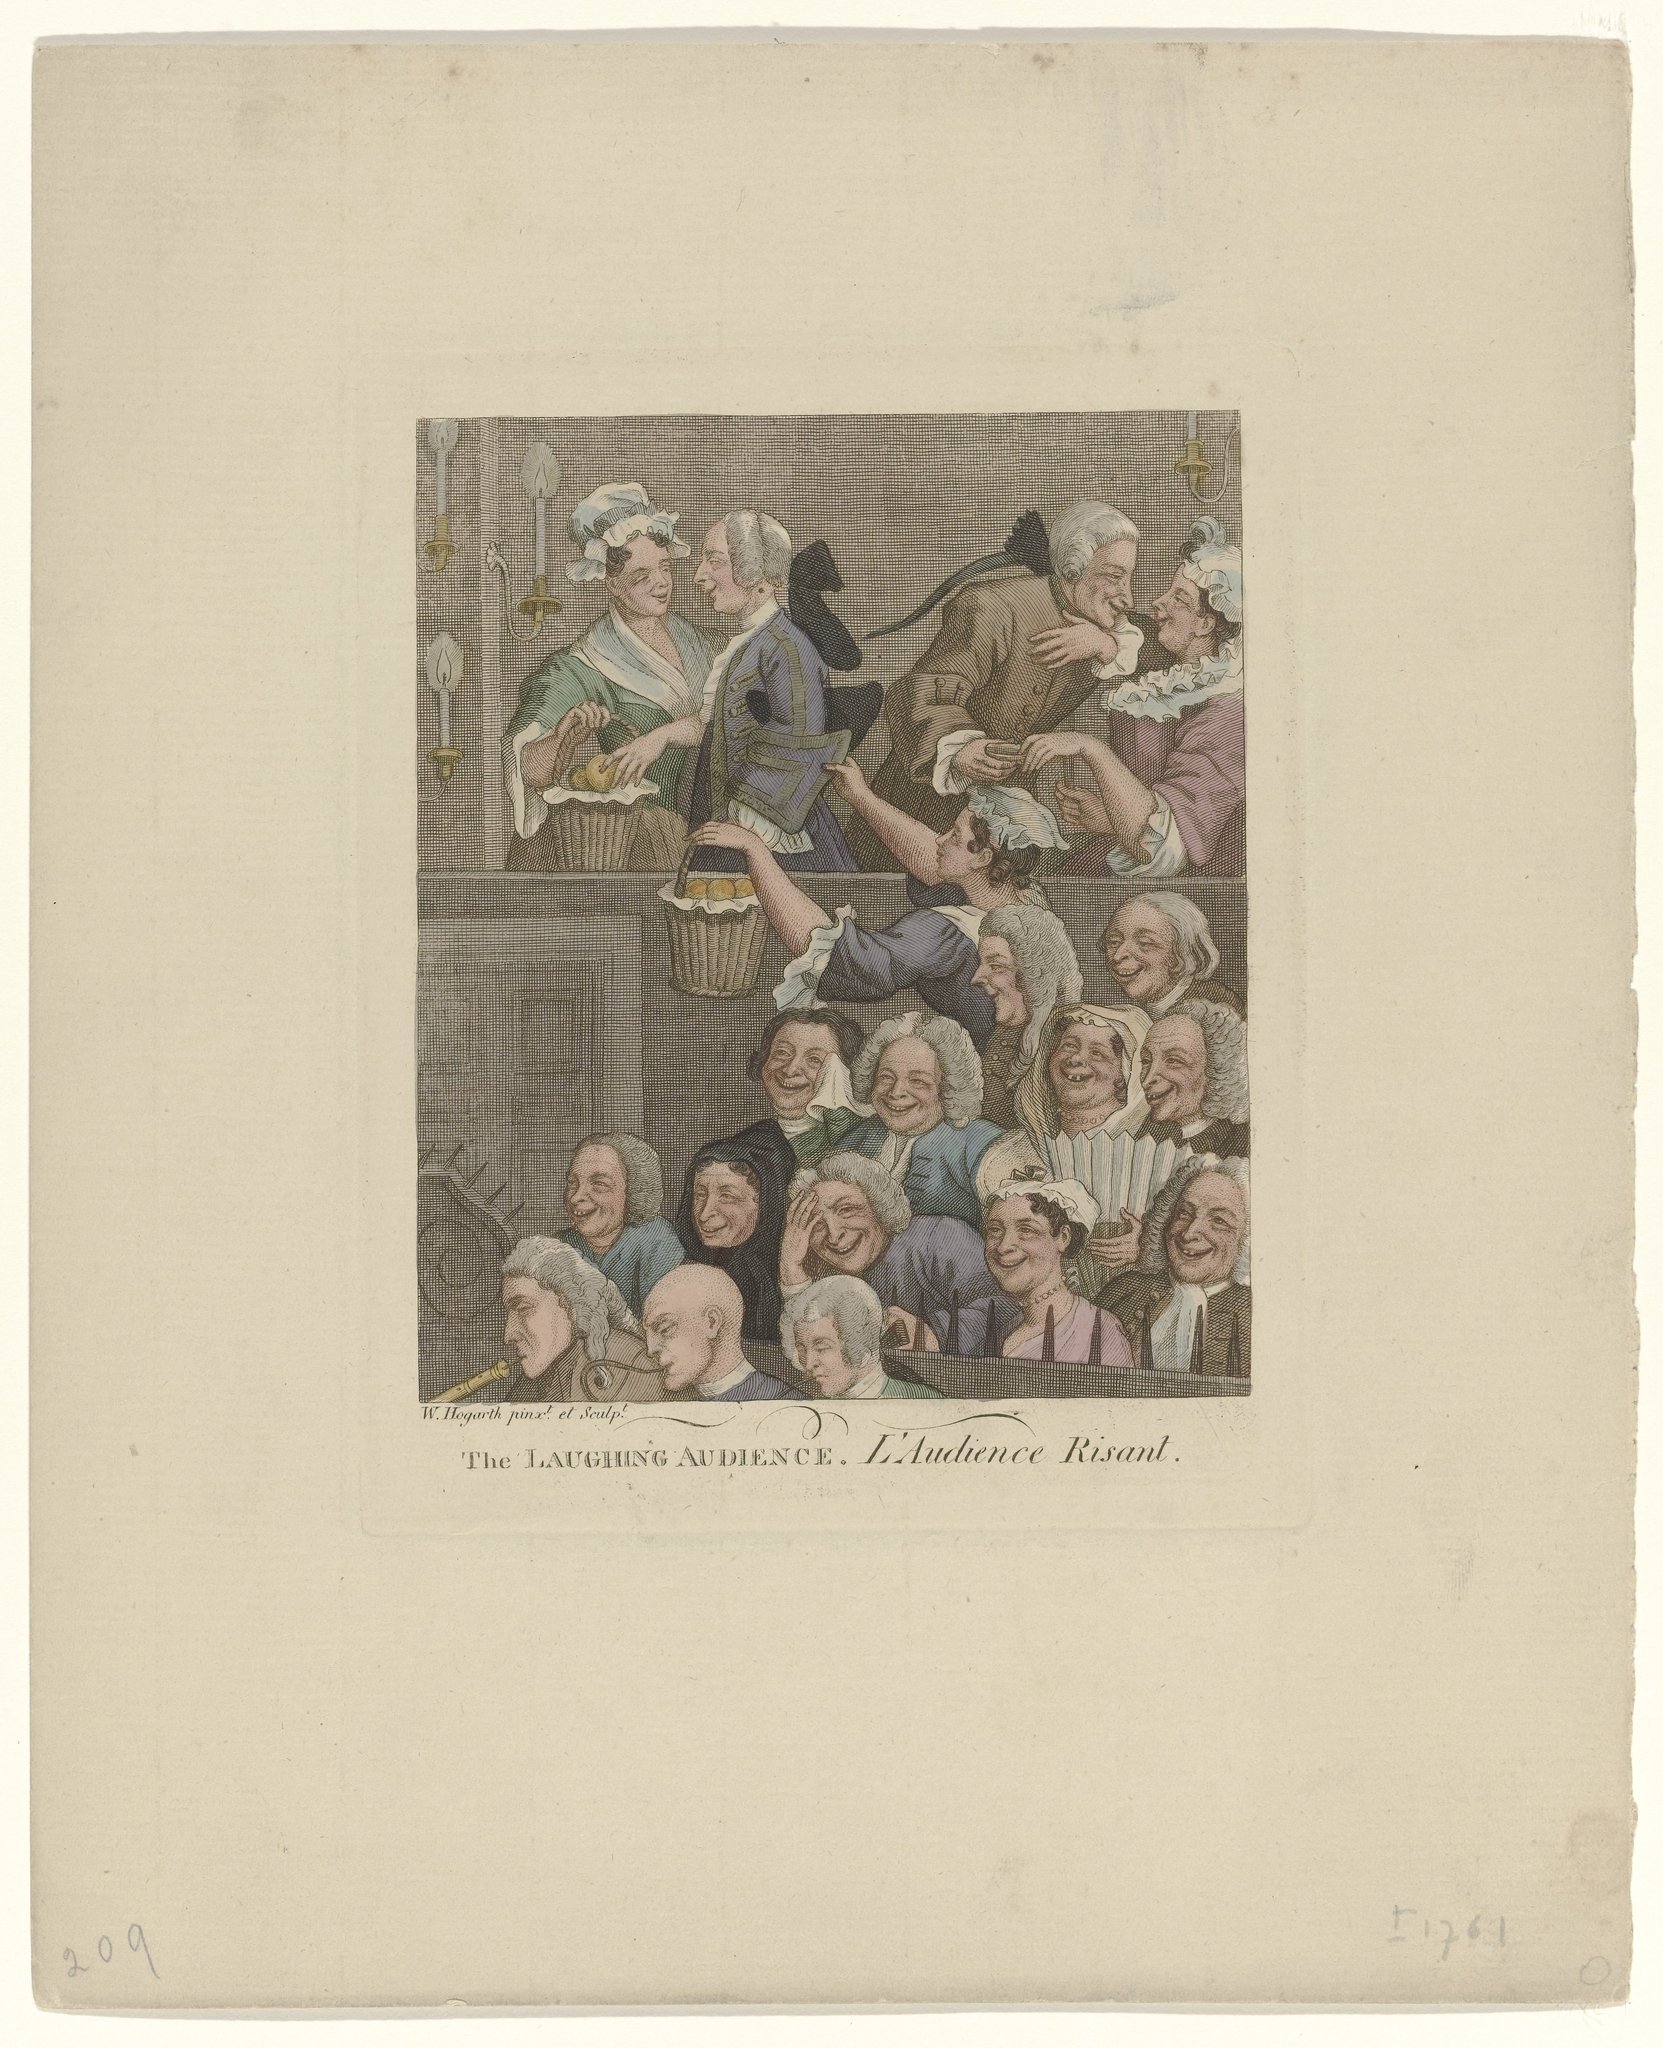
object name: cartoon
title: The Laughing Audience / L'Audience Risant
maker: william hogarth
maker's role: draughtsman, painter, print maker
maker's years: 1697-1764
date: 1761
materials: paper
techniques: etching, hand coloring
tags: clothing for the upper part of the body (+ women's clothes), head-gear (+ women's clothes), laughing, fashion plates, the audience ~ art performance, wig, neck-gear ~ clothing (+ women's clothes)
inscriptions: title: ‘L'Audience Risant’, title: ‘The Laughing Audience.’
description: Theaterpubliek, met op de voorgrond de hoofden van drie muzikanten uit het orkest. Achter hen een hek met daarachter het lachende publiek verspreid over drie rijen. Boven hen een balkon of loge met twee mannen en twee vrouwen, waarvan de linker een sinaasappelverkoopster is. Een staande vrouw in het publiek trekt aan de jas van de heer in de loge om een mand met sinaasappels aan te bieden. De eerste druk was ontworpen en gegraveerd door William Hogarth en verscheen in 1733. Deze ingekleurde prent met onderschrift is een latere druk uit ca. 1761.